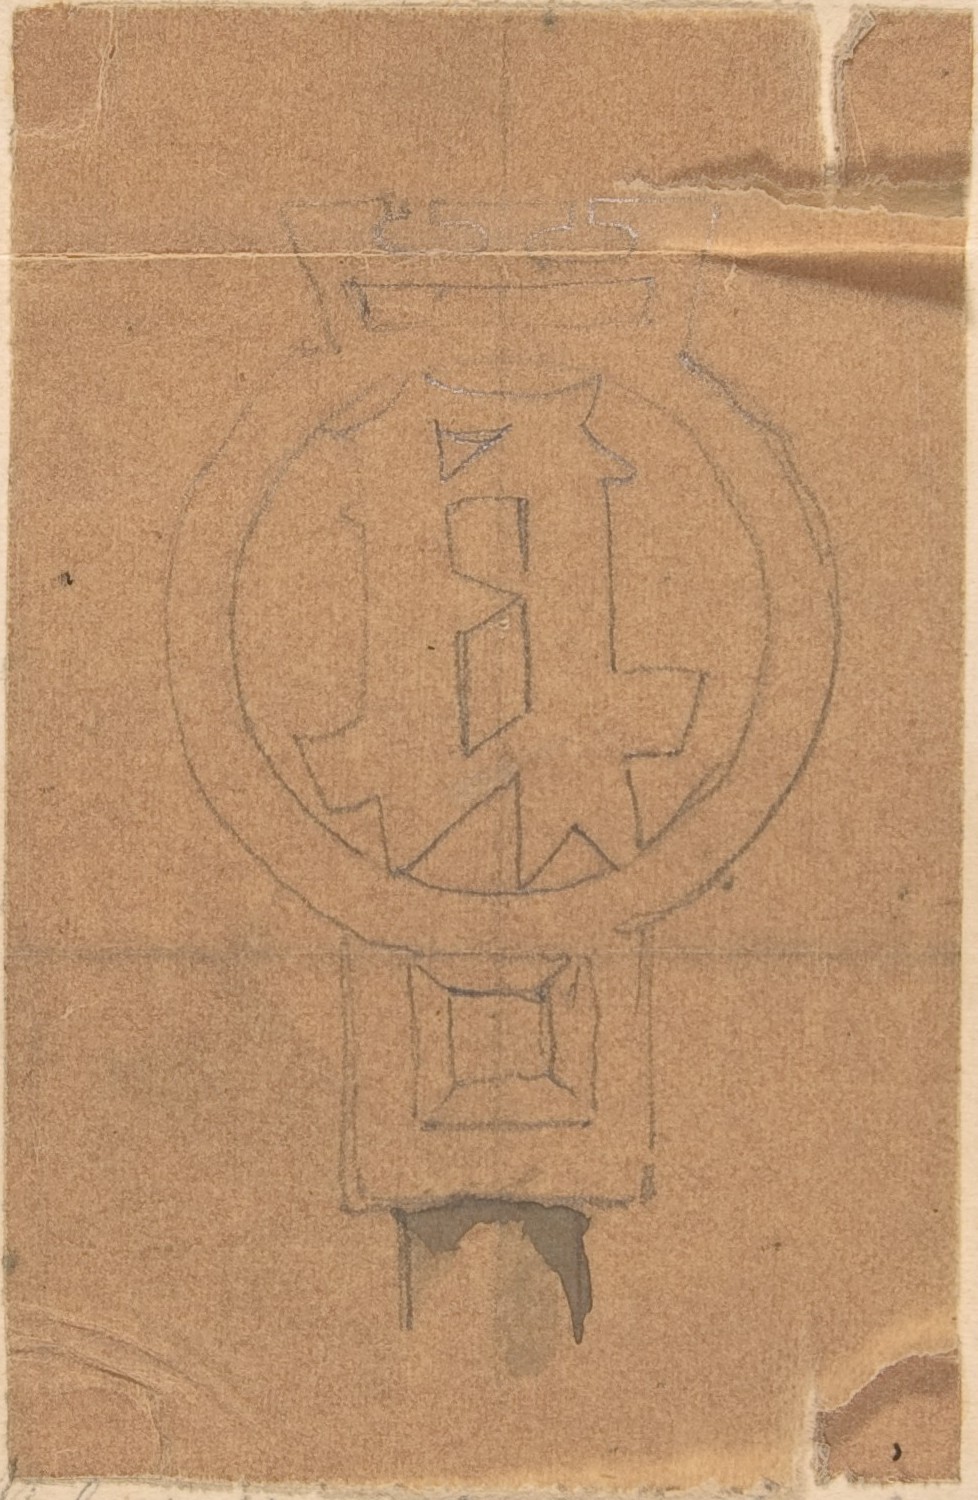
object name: drawing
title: 14th century Ornament from Blickling Church, Norfolk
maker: richardson ellson & co.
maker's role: artist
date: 1880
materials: graphite